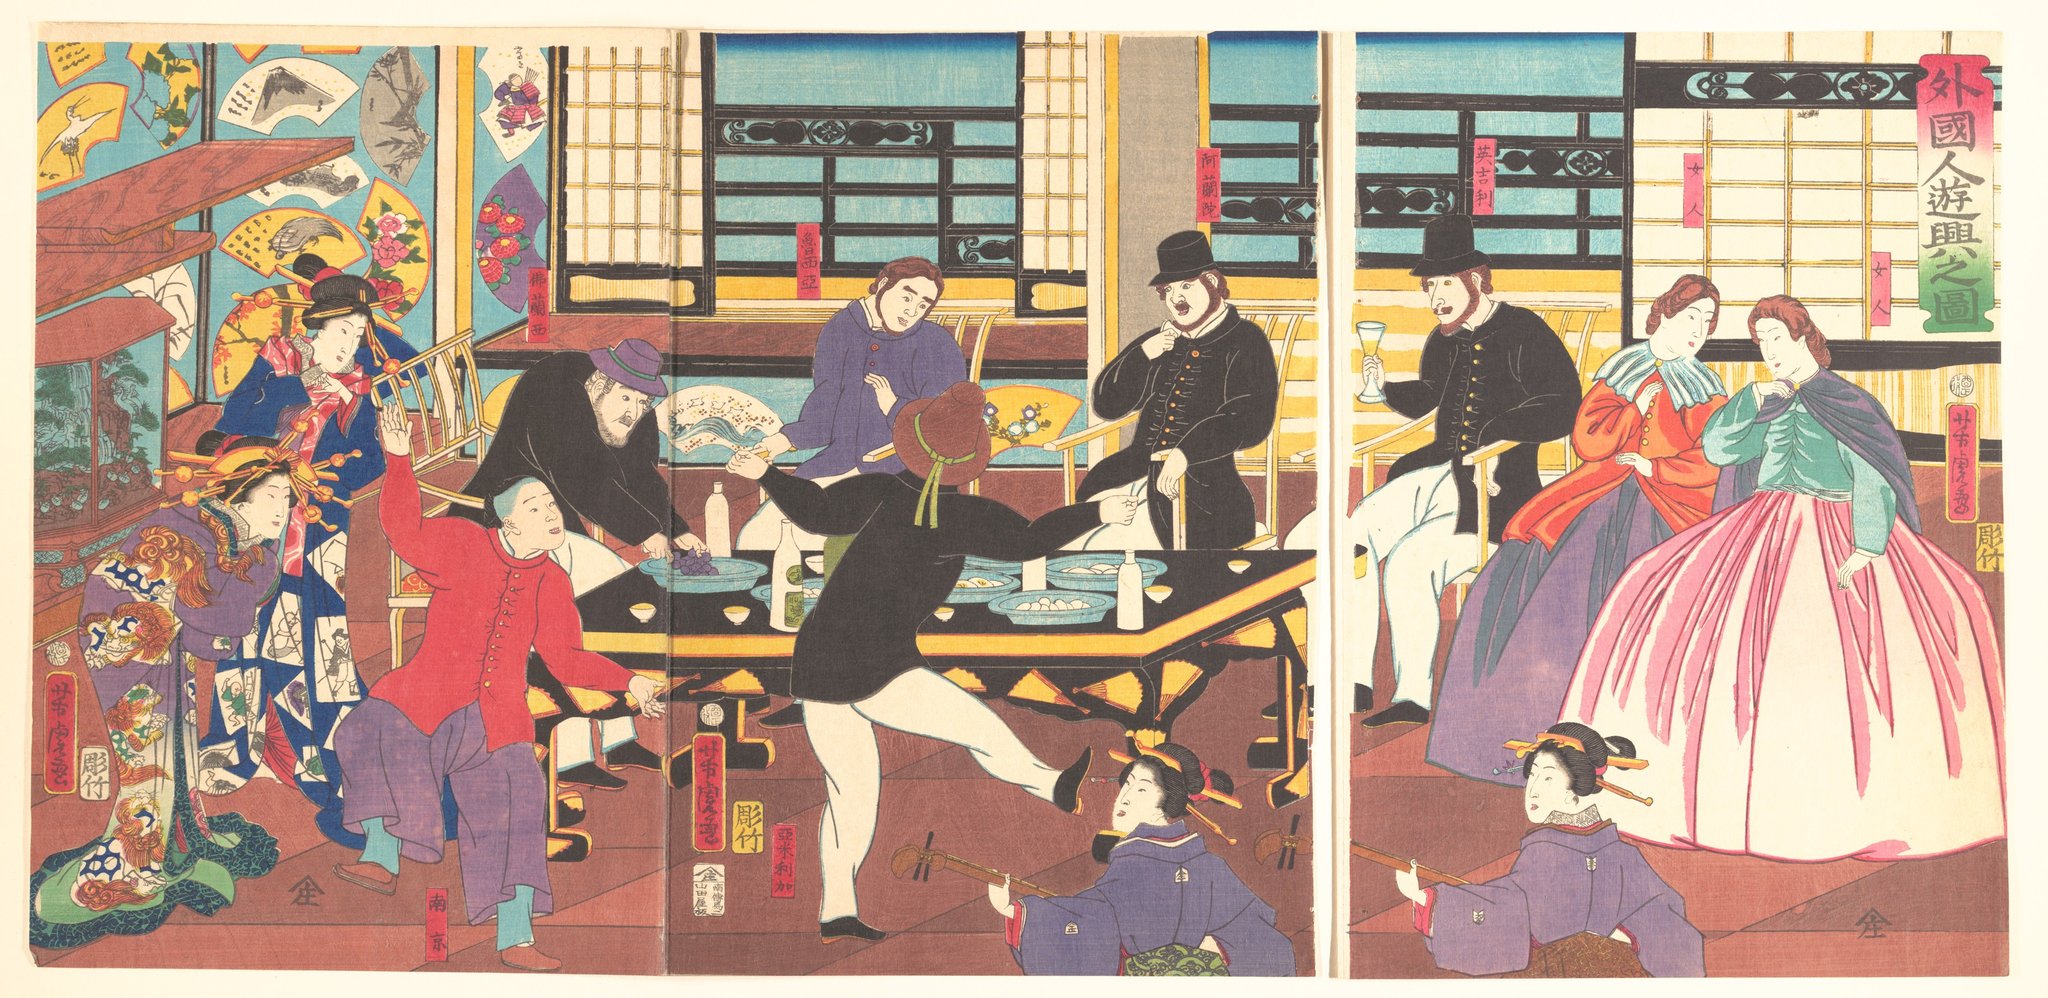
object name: print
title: Foreigners Enjoying a Party (Gaikokujin yūkyō no zu)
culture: japanese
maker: utagawa yoshitora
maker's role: artist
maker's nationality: japanese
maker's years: 1845-1880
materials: ink, paper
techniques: nishiki e, woodblock print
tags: men,women,party,dancing